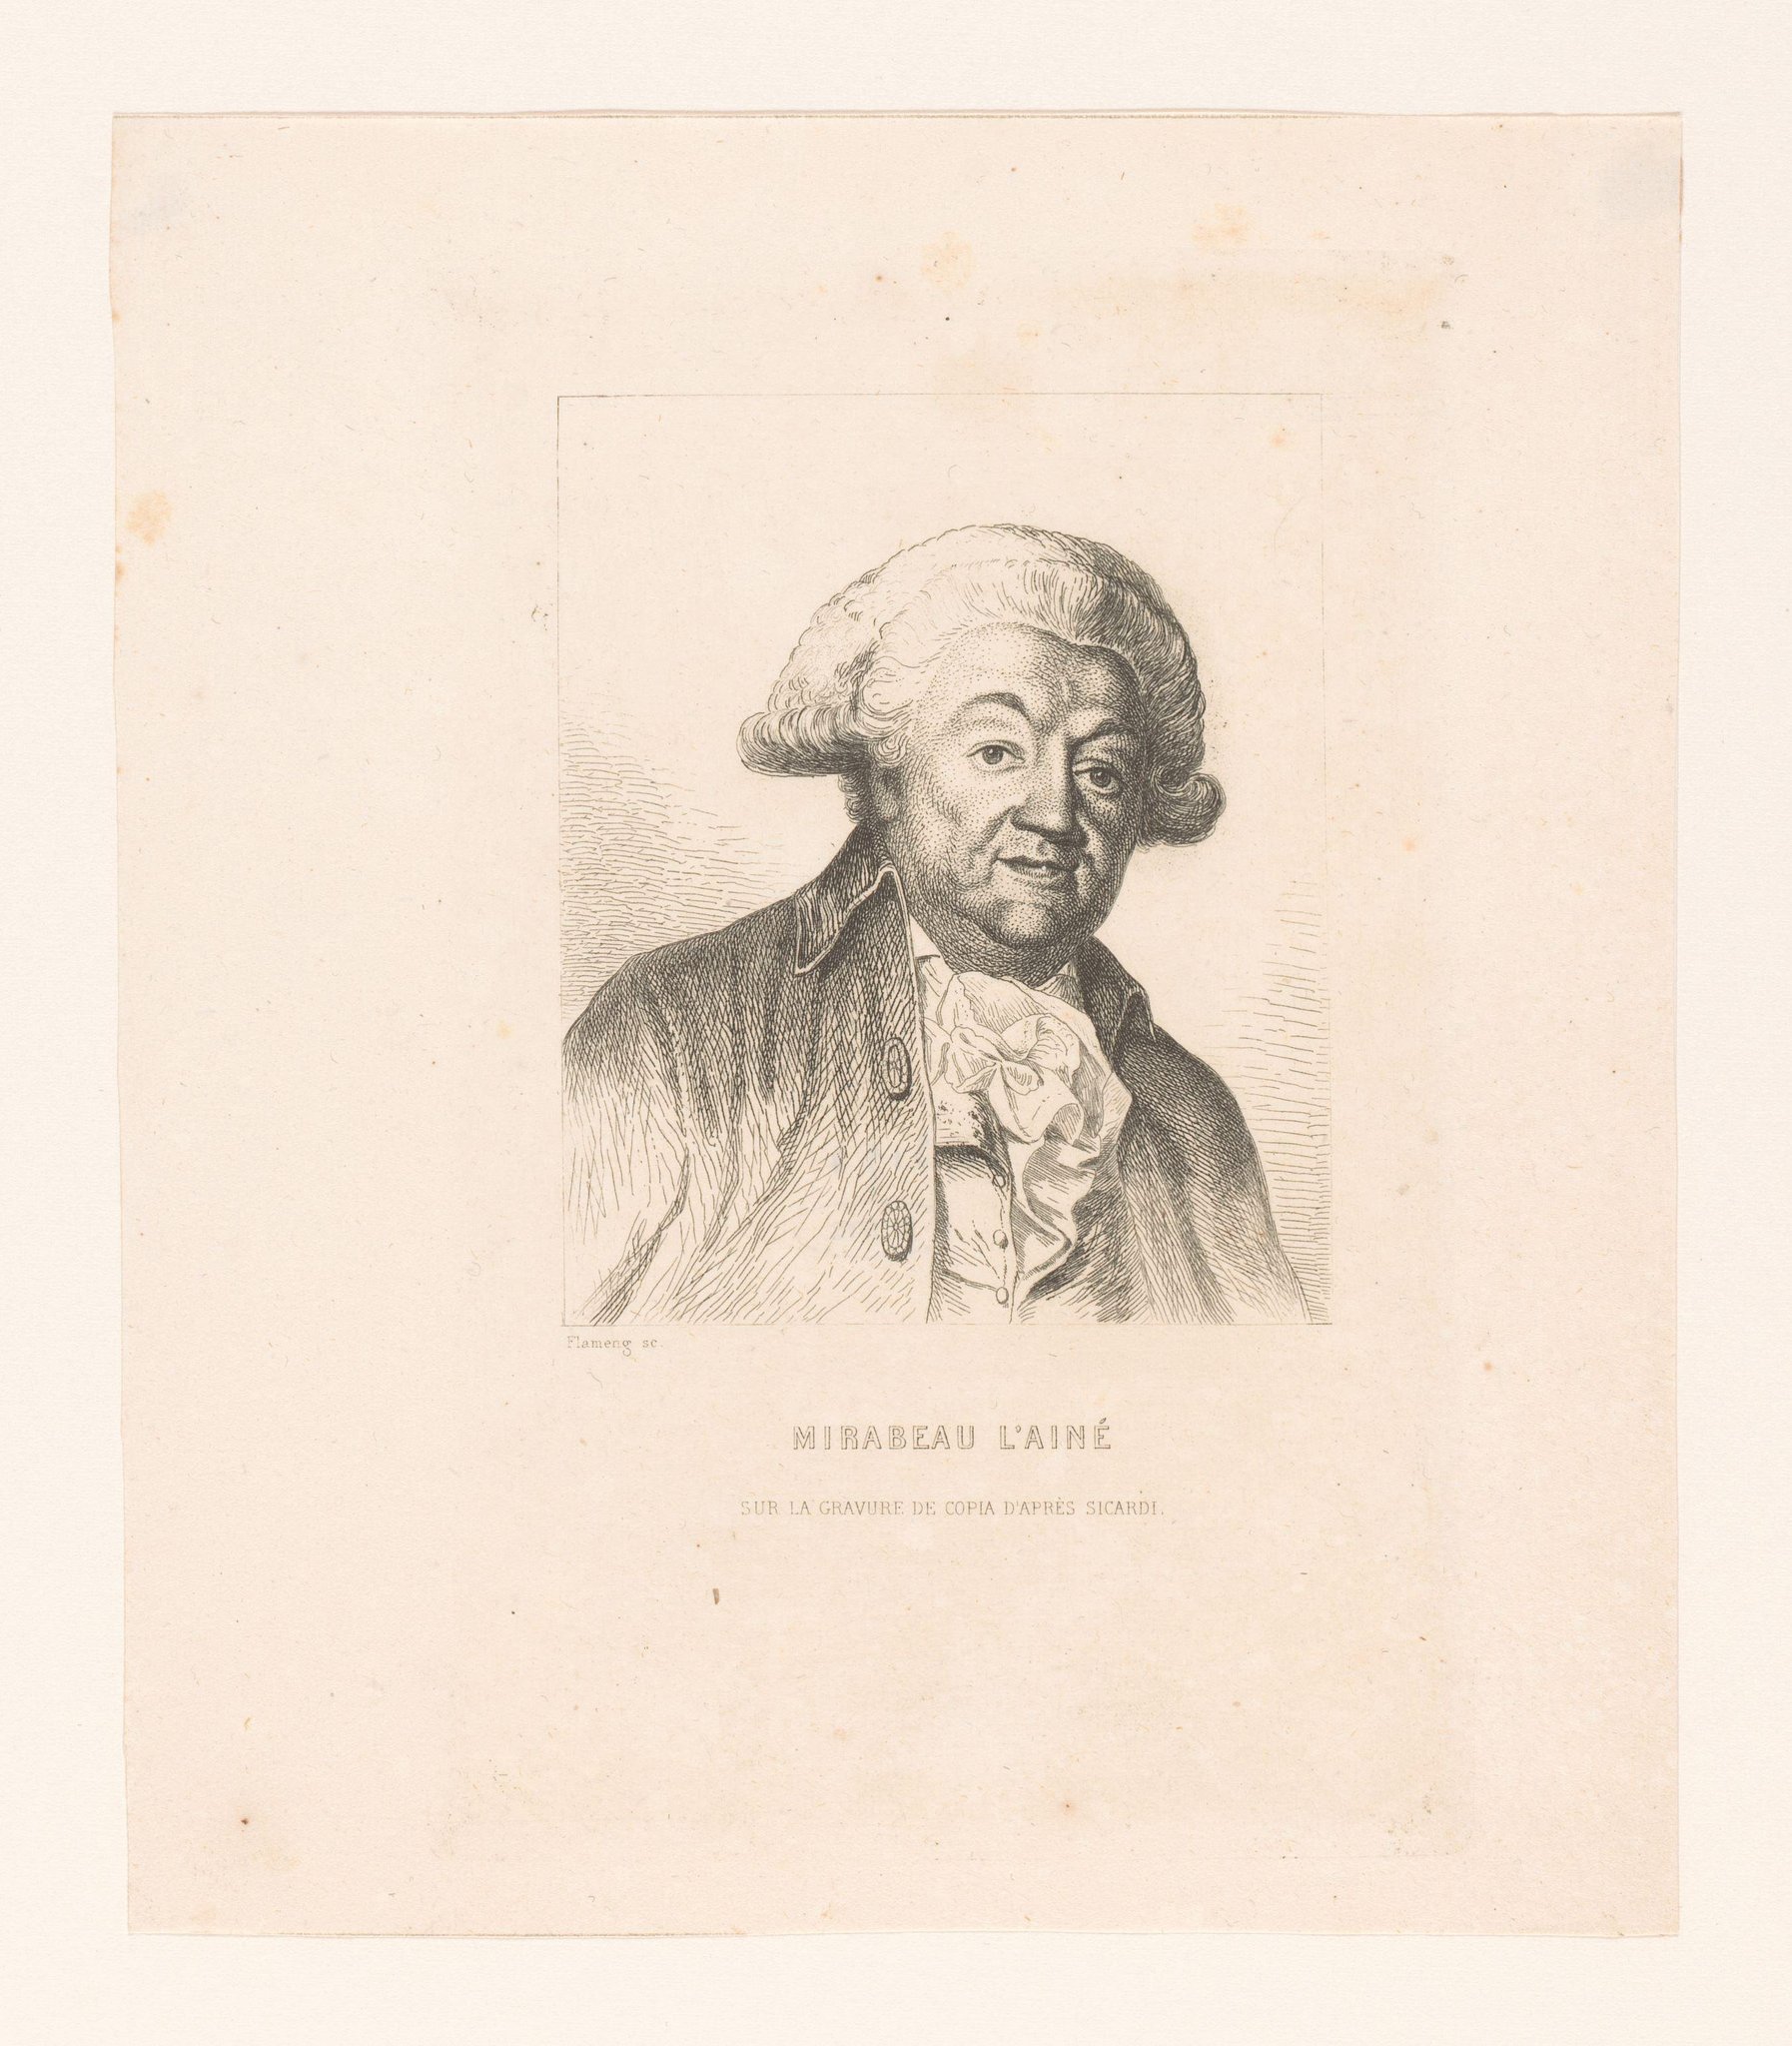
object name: print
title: Mirabeau l'ainé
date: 1841-1910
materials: paper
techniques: etching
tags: paris, politician, honoré-gabriel de riqueti (graaf van mirabeau), historical persons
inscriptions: collector's mark: Lugt 2228